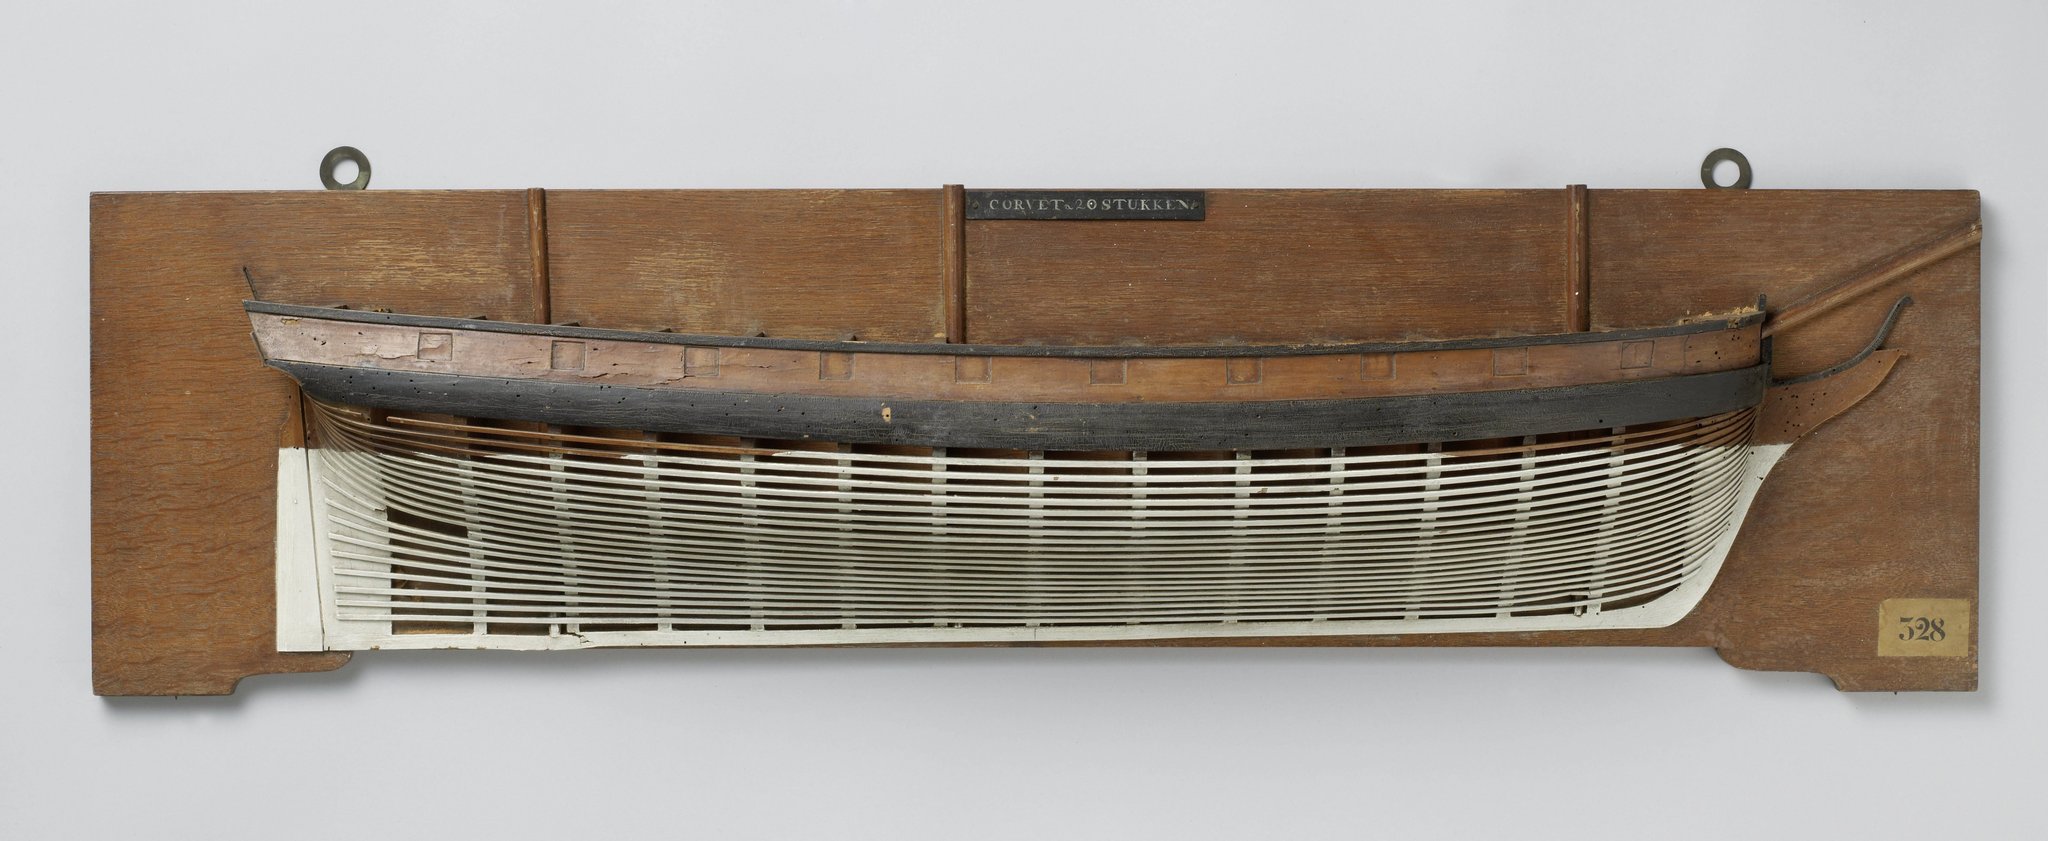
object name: ship model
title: Half Model of a 20-Gun Sloop of War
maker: Anonymous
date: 1780-1820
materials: wood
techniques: polychromy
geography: netherlands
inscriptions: label, bottom right: ‘328’ former inventory label, inscription, top centre, on a rectangular black label: ‘CORVET a 20 STUKKEN.’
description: Gepolychromeerd mallenmodel (stuurboord) van een driemaster. De huid boven het barkhout gesloten. Tien geschutpoorten aangegeven op één dek, dat gesloten is. Gewrongen spiegel, gesloten hol wulf, geen details van het hek, geen zijgalerij; recht roer met vierkante roerkoning. Zeeg voor en achter iets oplopend, één barkhout. Gepiekt rondspant.